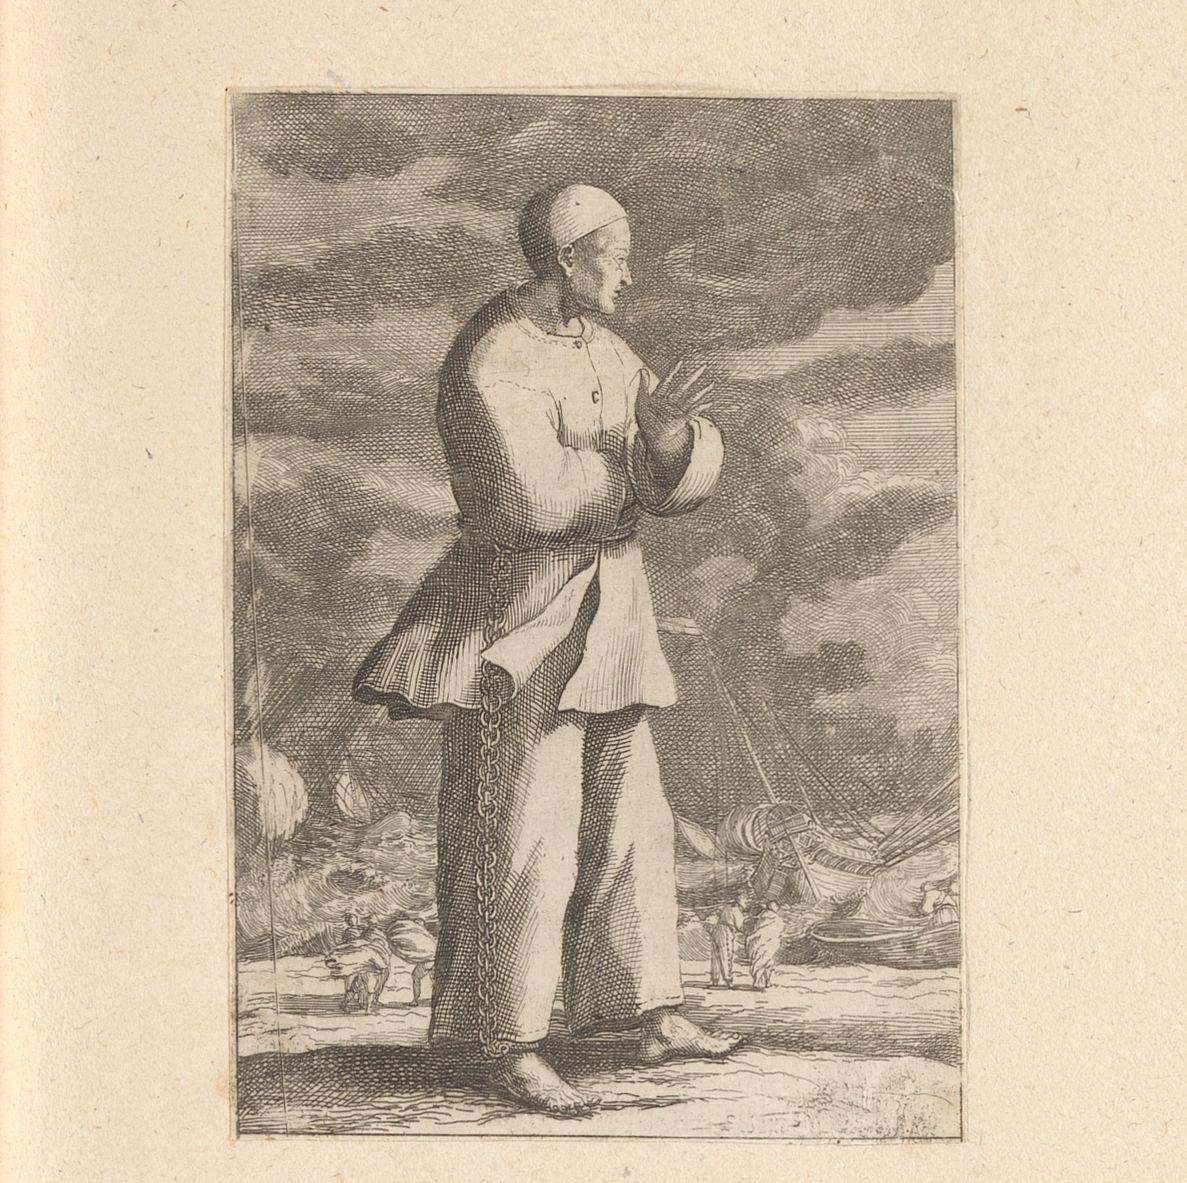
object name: print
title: Verschillende figuren en kostuums uit Metz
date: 1647-1701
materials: paper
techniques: engraving, etching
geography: metz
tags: master ~ enslaved person, slave-trade, slavery; serfs and enslaved persons, folk costume, regional costume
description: Prent maakt deel uit van een 28-delige serie met verschillende figuren uit Metz in de regionale mode. Leclerc vervaardigde de platen te Metz. Landry gaf slechts twintig van de prenten in een serie uit.